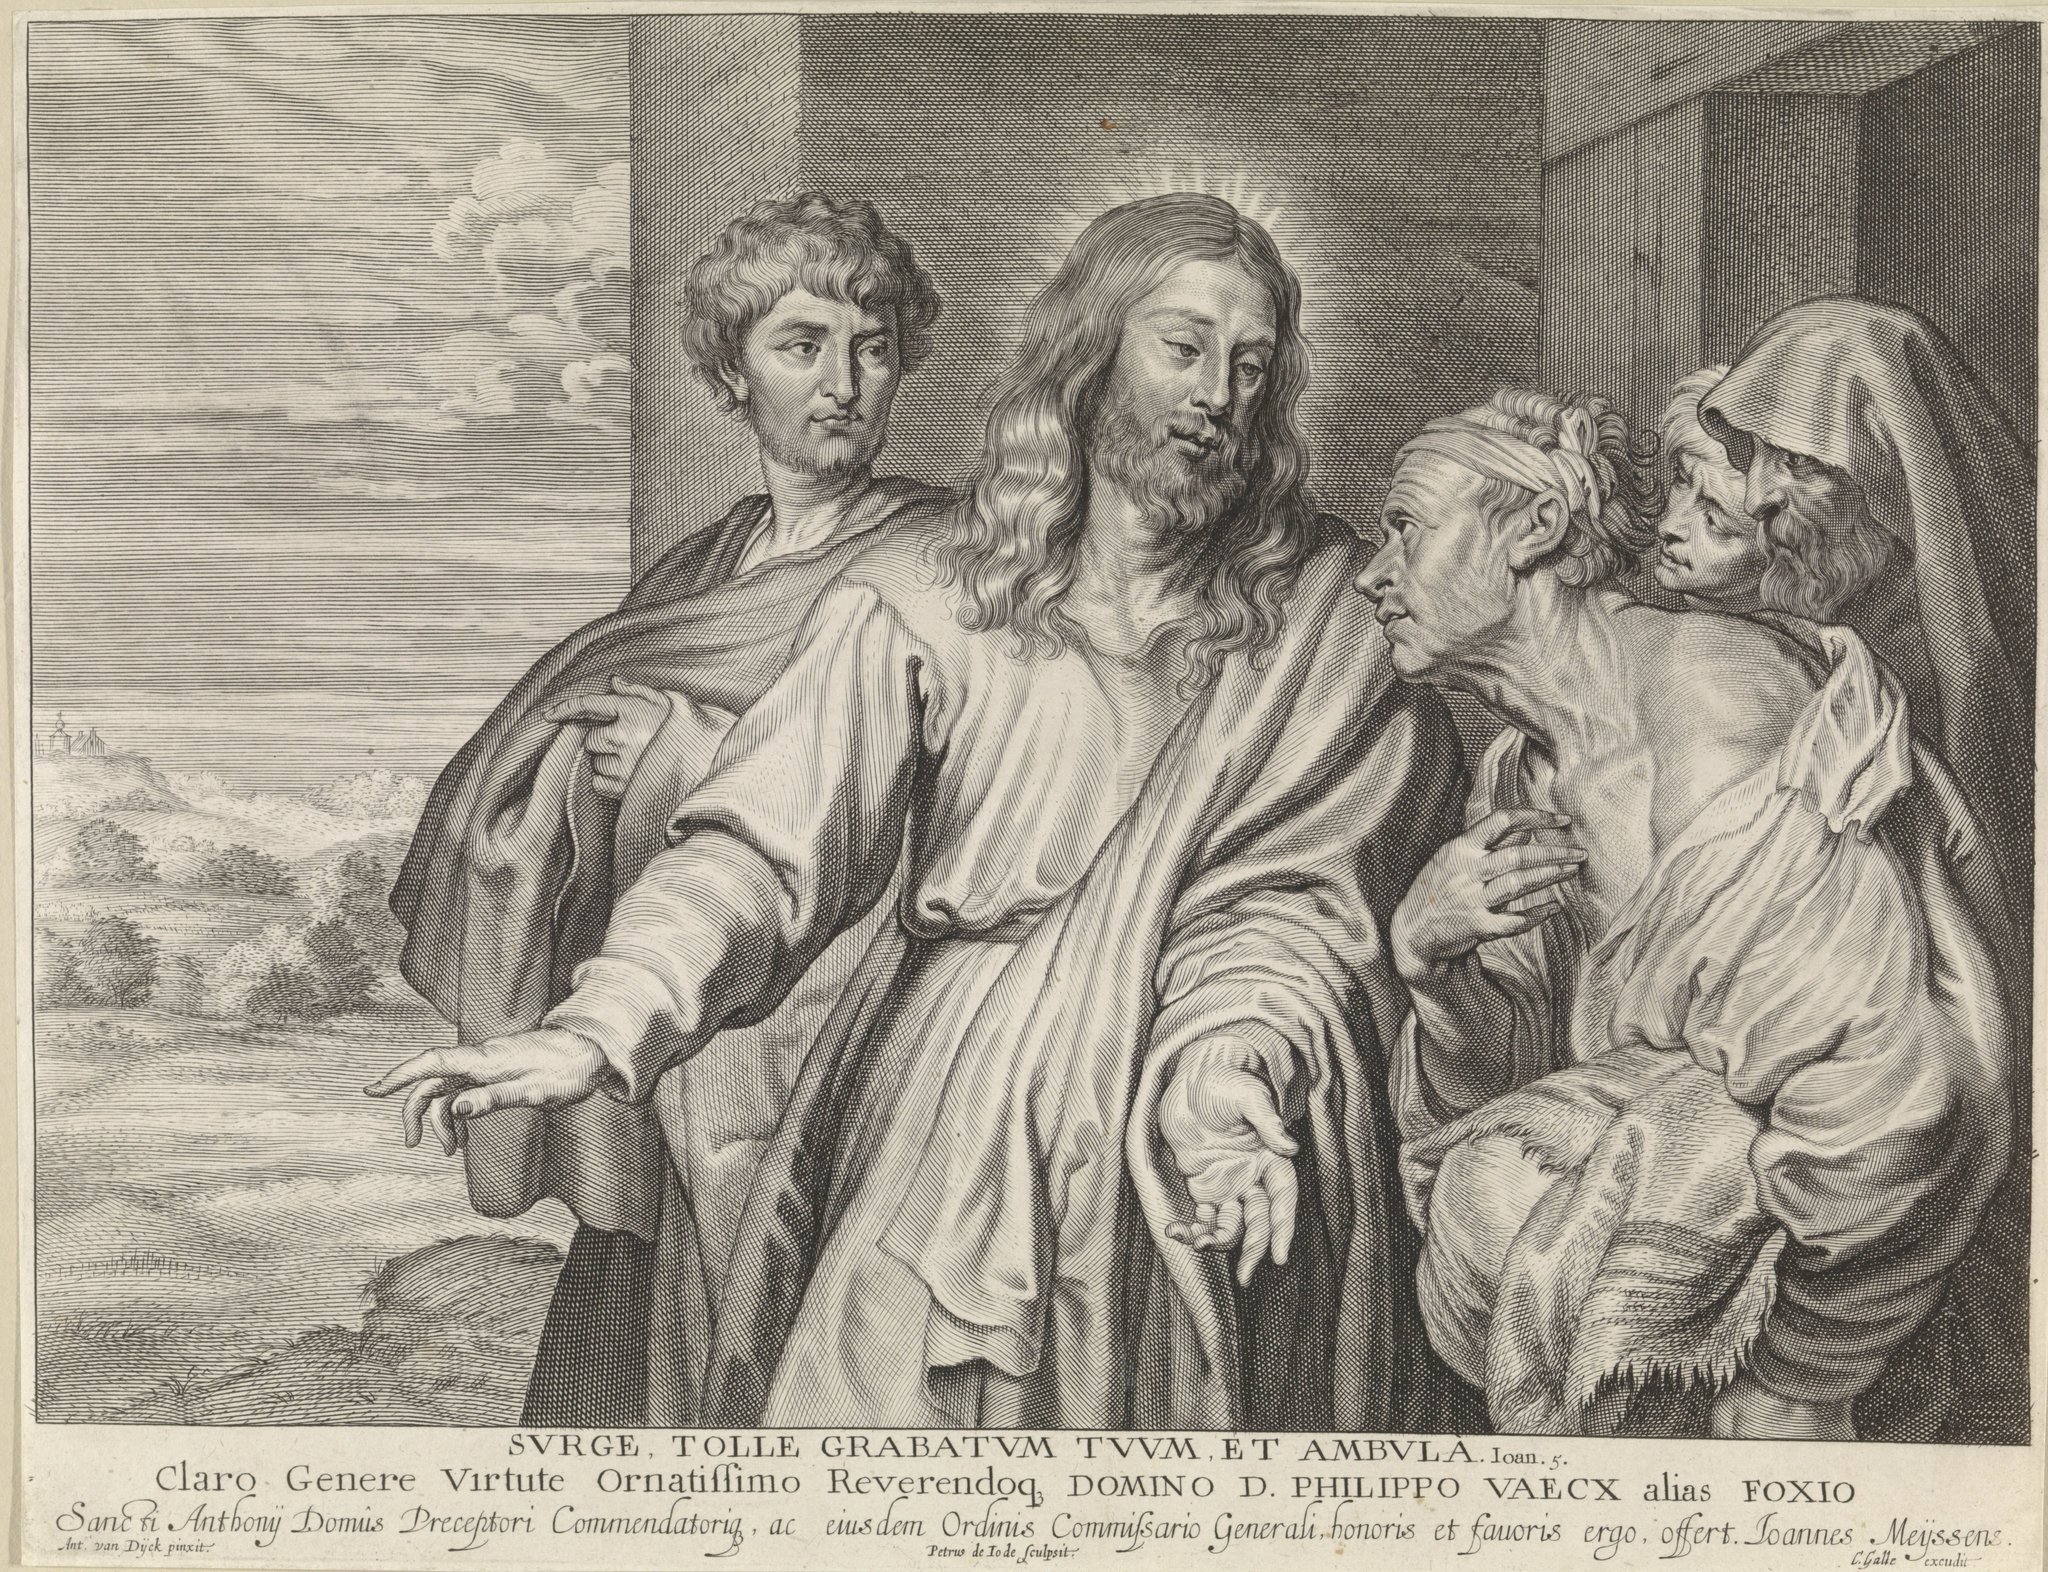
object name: print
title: Christus geneest een verlamde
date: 1628-1670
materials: paper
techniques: engraving, etching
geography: antwerp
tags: sick people lying near the pool of bethesda ~ christ healing paralytics (john 5:1-9)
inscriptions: collector's mark: Lugt 240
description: Christus geneest een verlamde man. Drie mensen kijken toe. Links op de achtergrond gezicht op een landschap. In de marge een onderschrift in het Latijn uit Johannes 5.